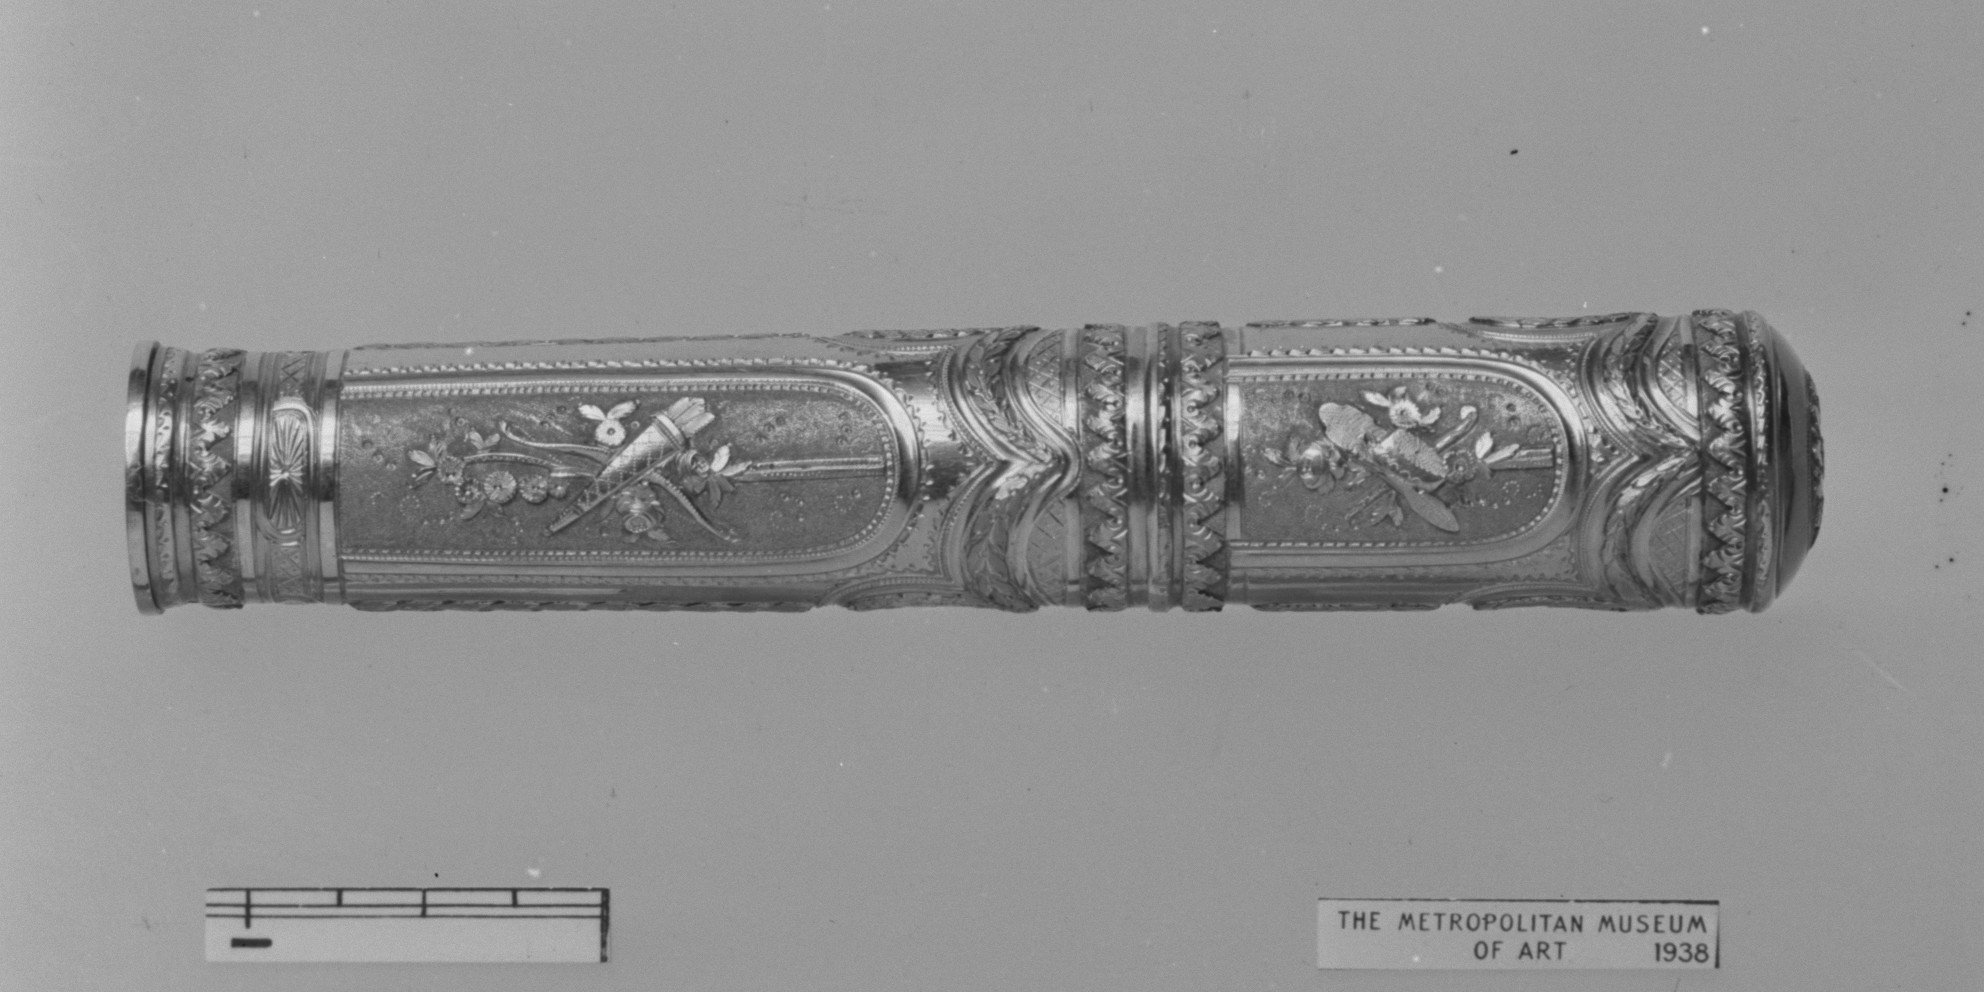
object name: étui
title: Sealing wax case (étui)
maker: melchior-rené barré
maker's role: maker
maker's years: 1738-1791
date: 1774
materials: gold